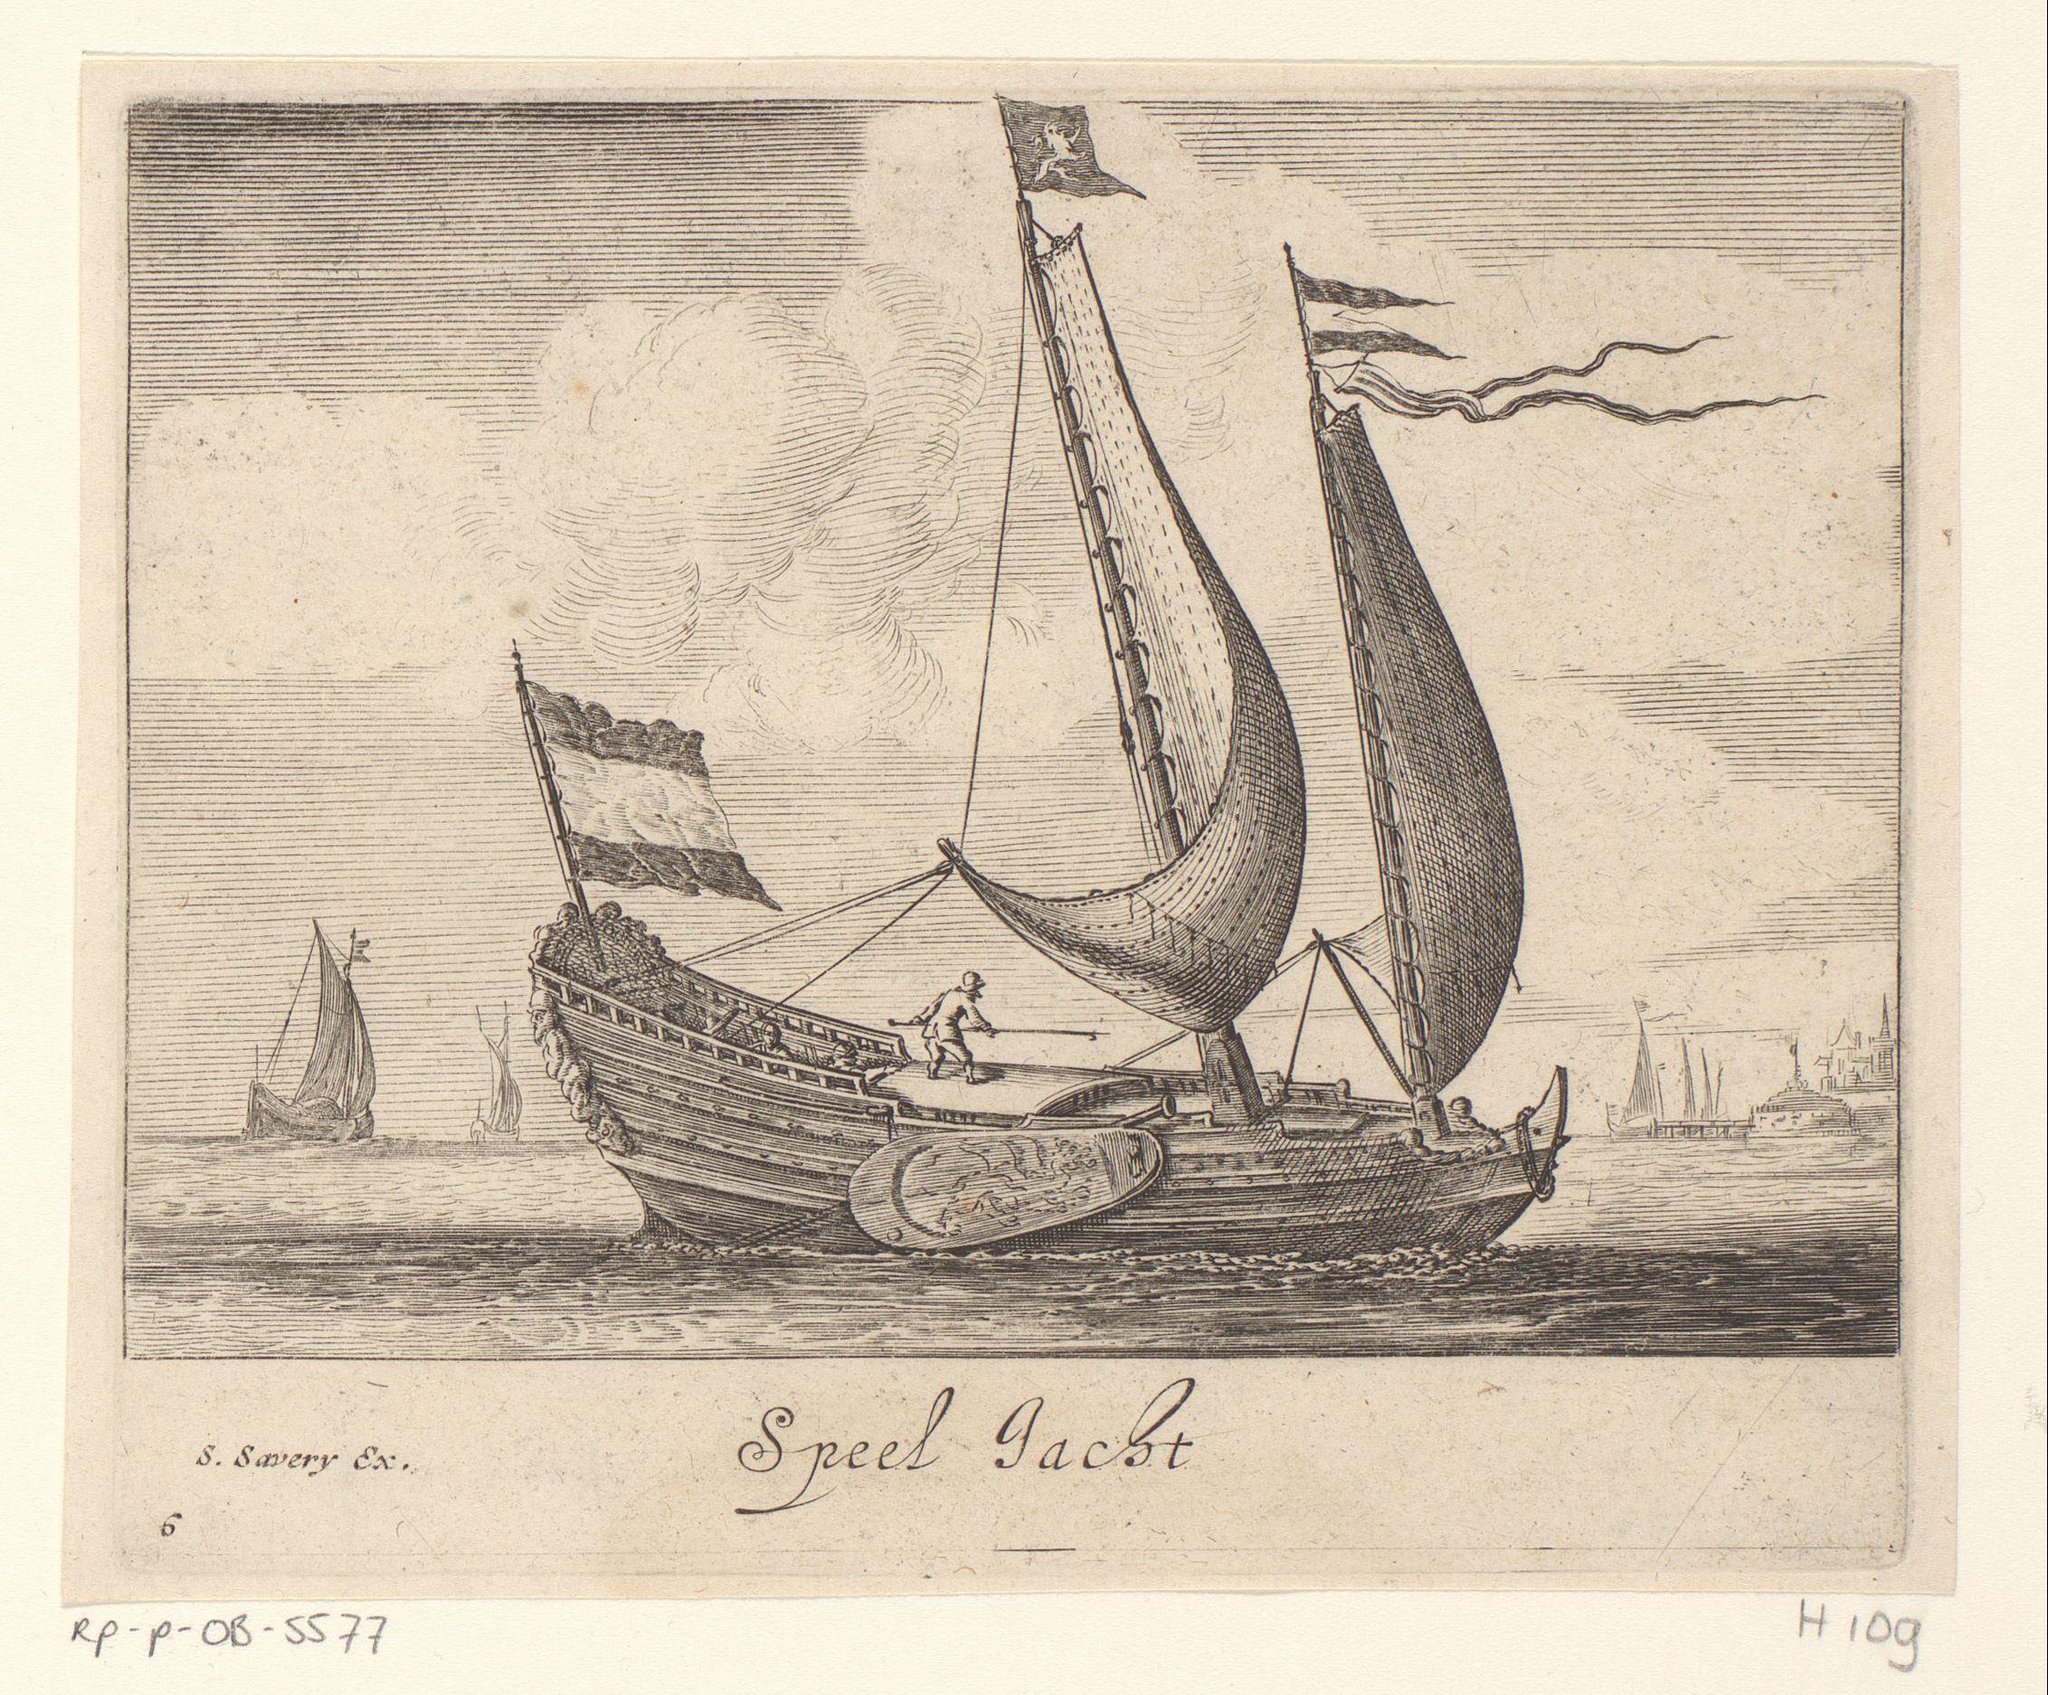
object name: print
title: Zeilschepen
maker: salomon savery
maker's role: print maker, publisher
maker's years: 1594-1683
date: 1610-1665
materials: paper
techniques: engraving, etching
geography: amsterdam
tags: sailing-ship, sailing-boat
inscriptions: collector's mark: Lugt 2228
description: De prent maakt deel uit van een zesdelige serie met voorstellingen van verschillende zeilschepen.